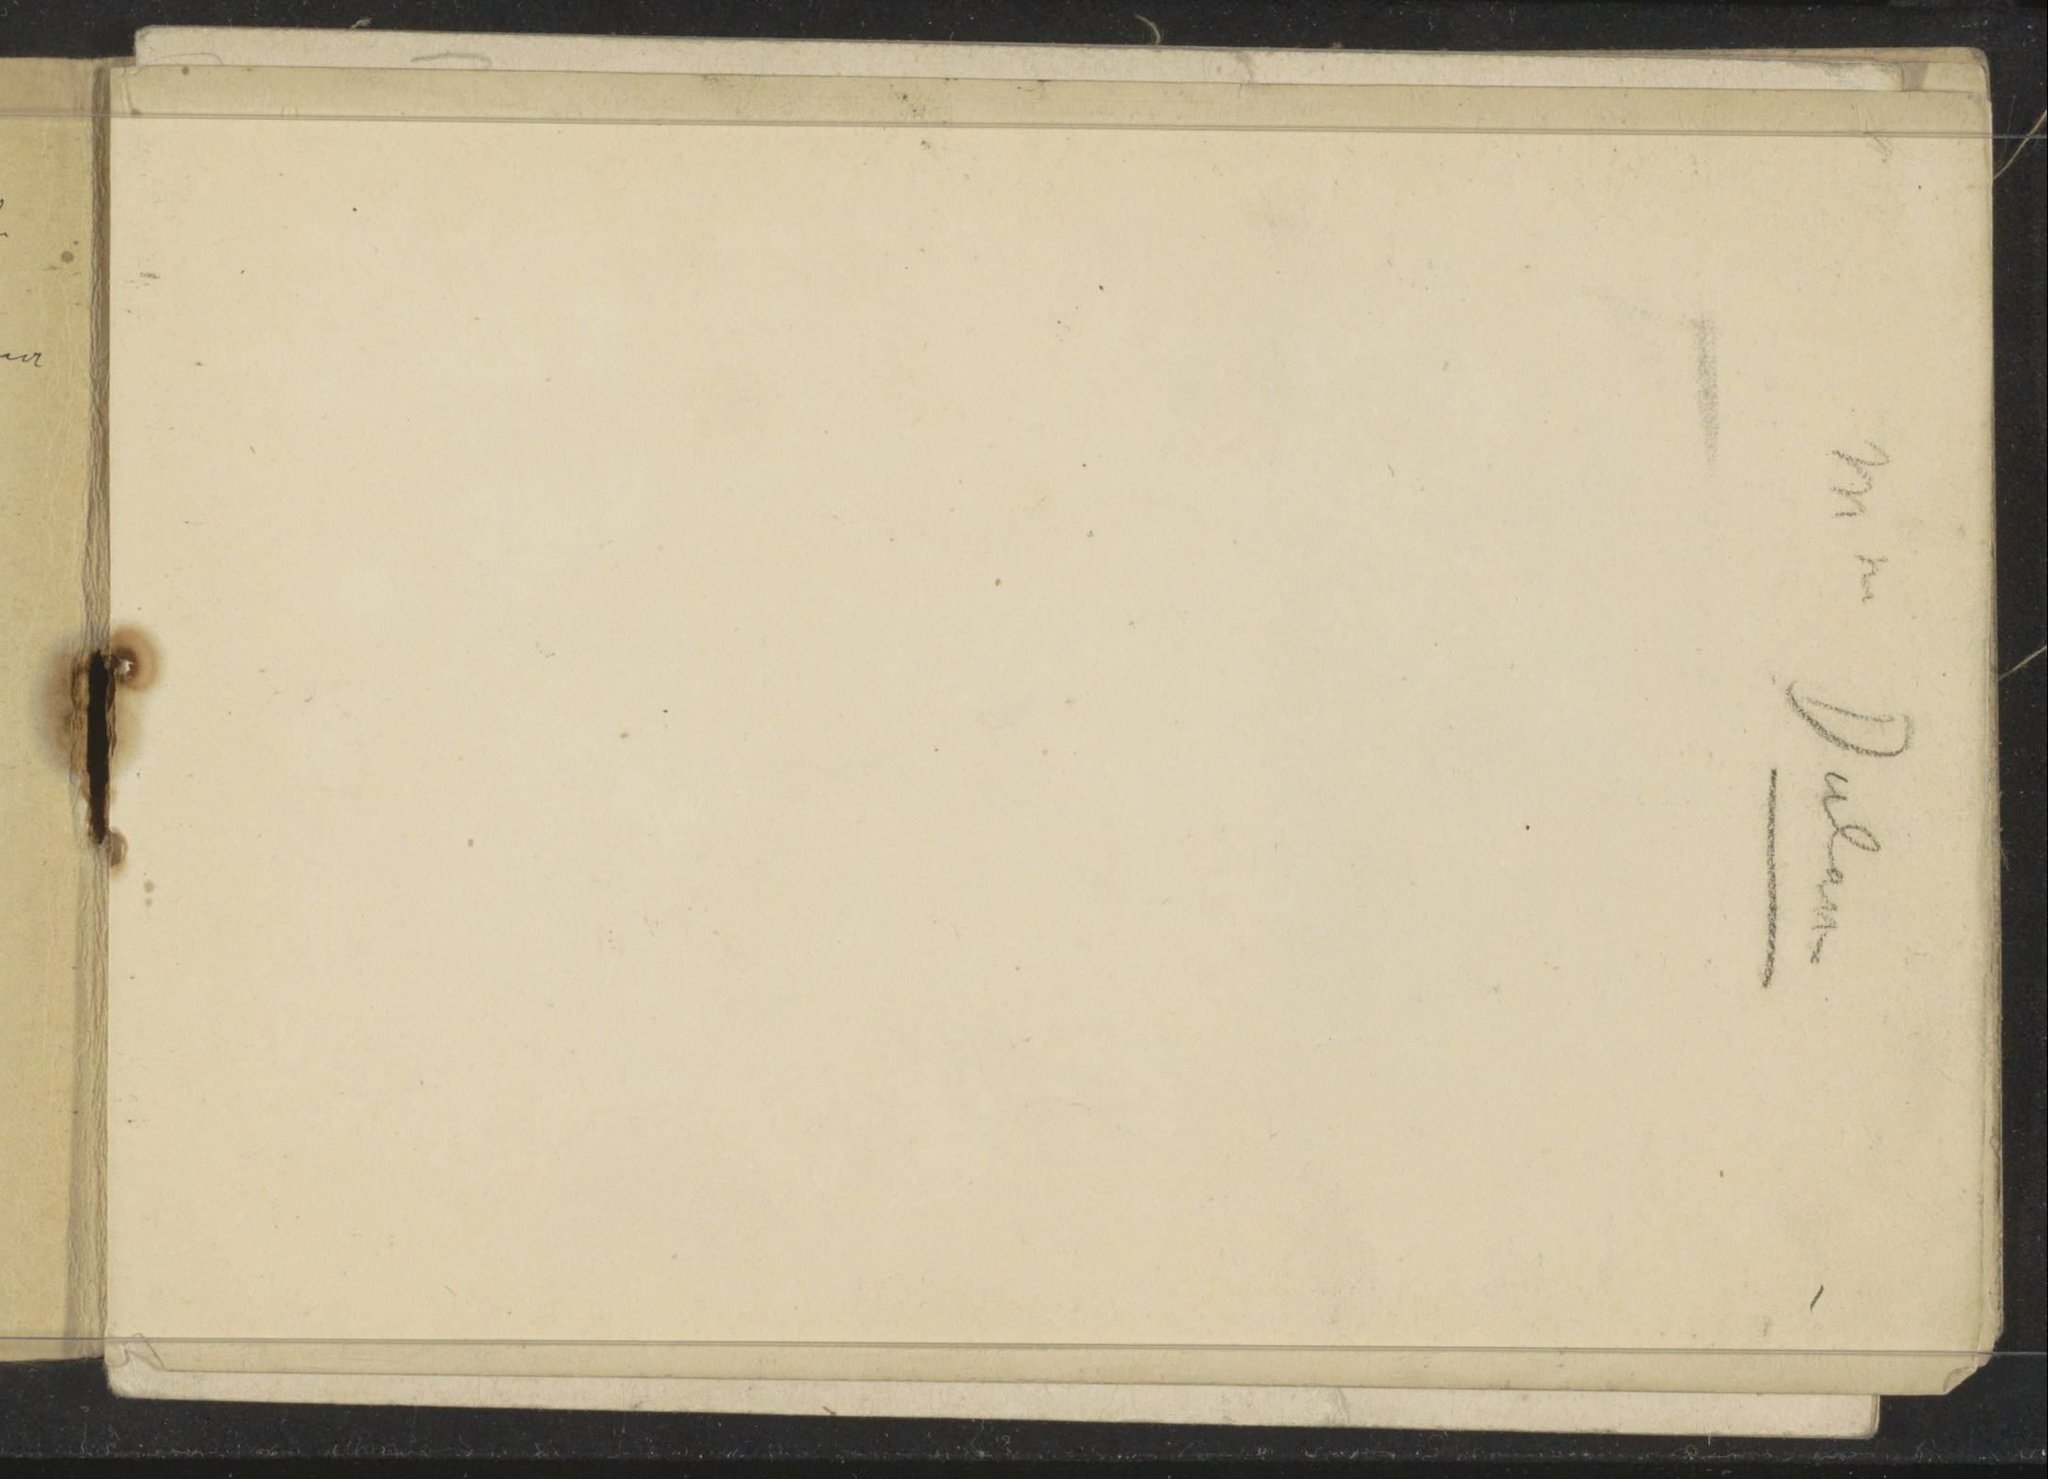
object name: sketchbook leaf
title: Annotatie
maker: isaac israels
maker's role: draughtsman, painter, print maker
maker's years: 1865-1934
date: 1923-1934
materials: chalk, paper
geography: the hague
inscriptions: annotation: ‘Mm Dula[...]’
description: Blad 1 recto uit schetsboek LVIII met 14 bladen.